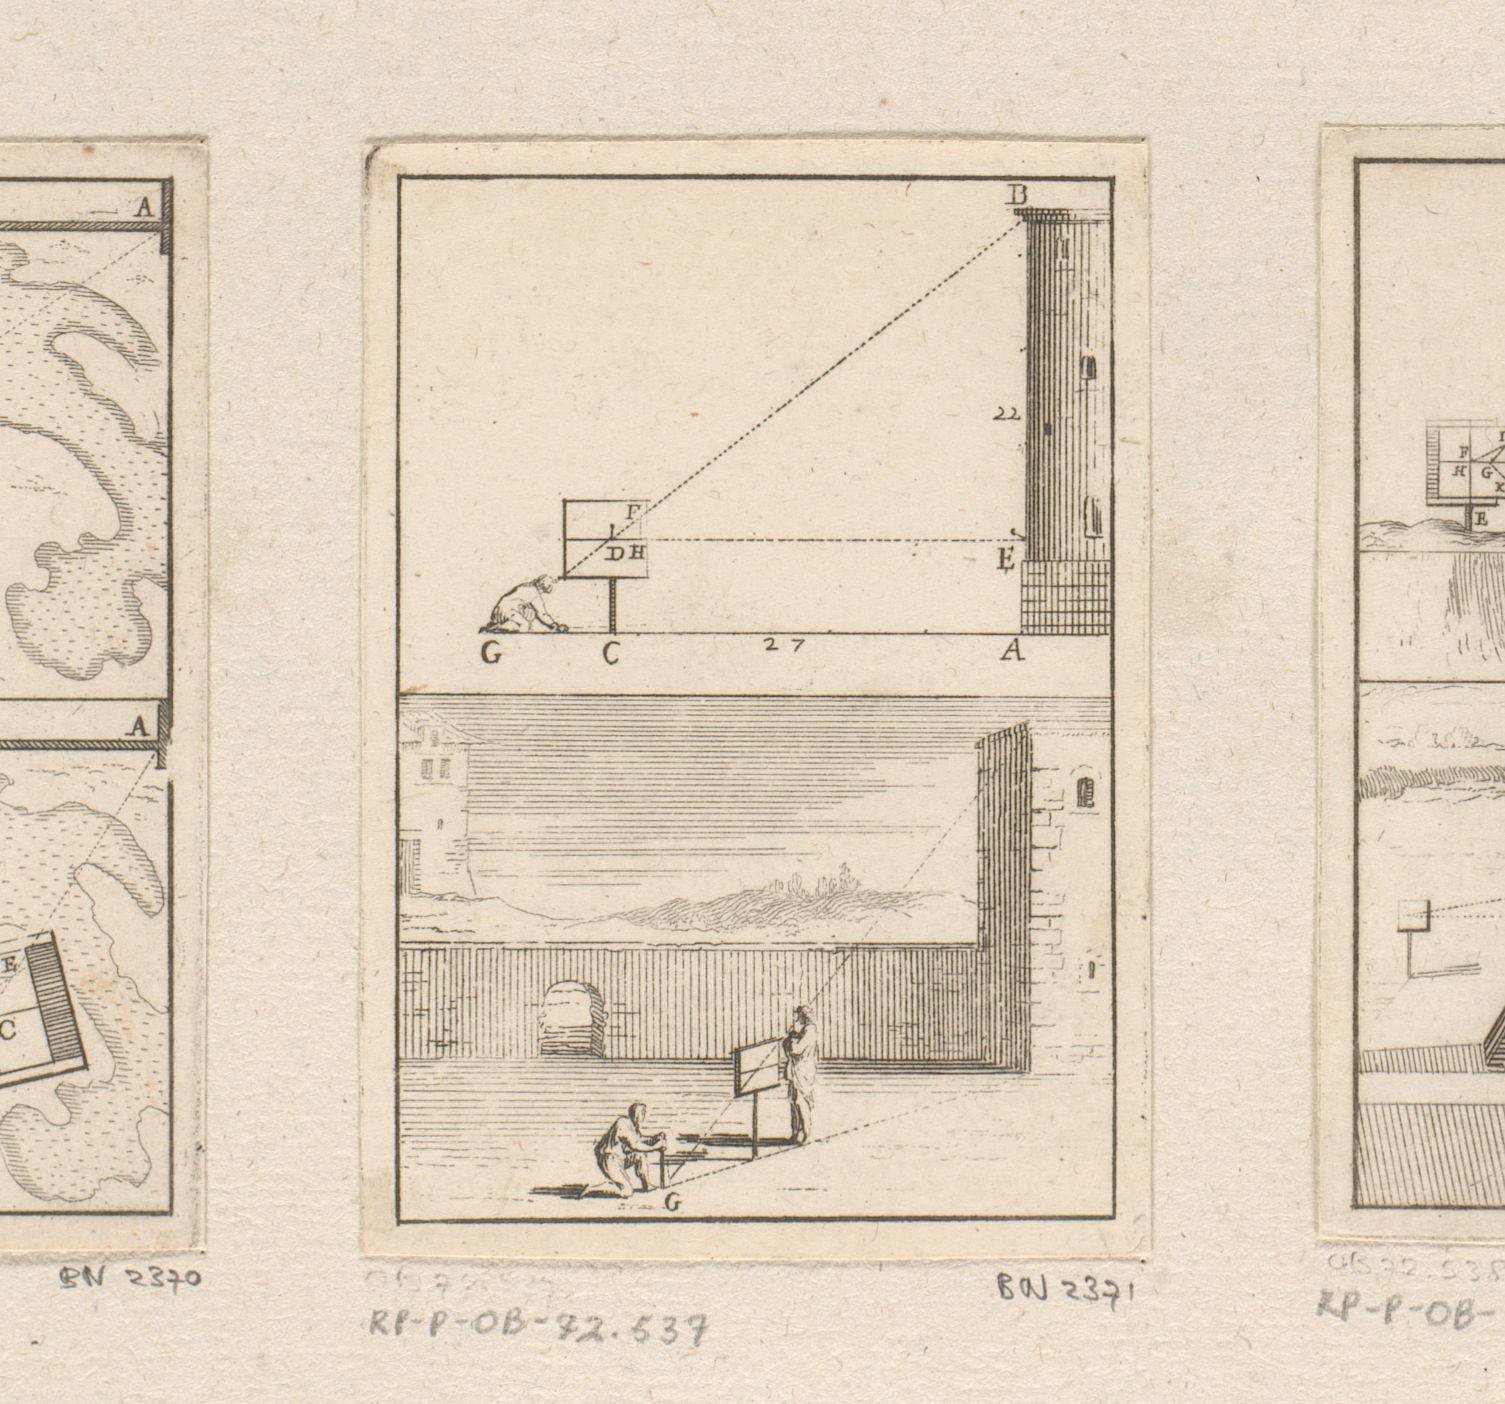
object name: book illustration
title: Opmeten van de hoogte van een gebouw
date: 1669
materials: paper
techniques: etching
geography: paris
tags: planimetry, geometry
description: Prent toegevoegd aan: Pratique de la géometrie, sur le papier et sur le terrain. Avec un nouvel ordre et une méthode particulière. Parijs: Thomas Jolly, 1669.